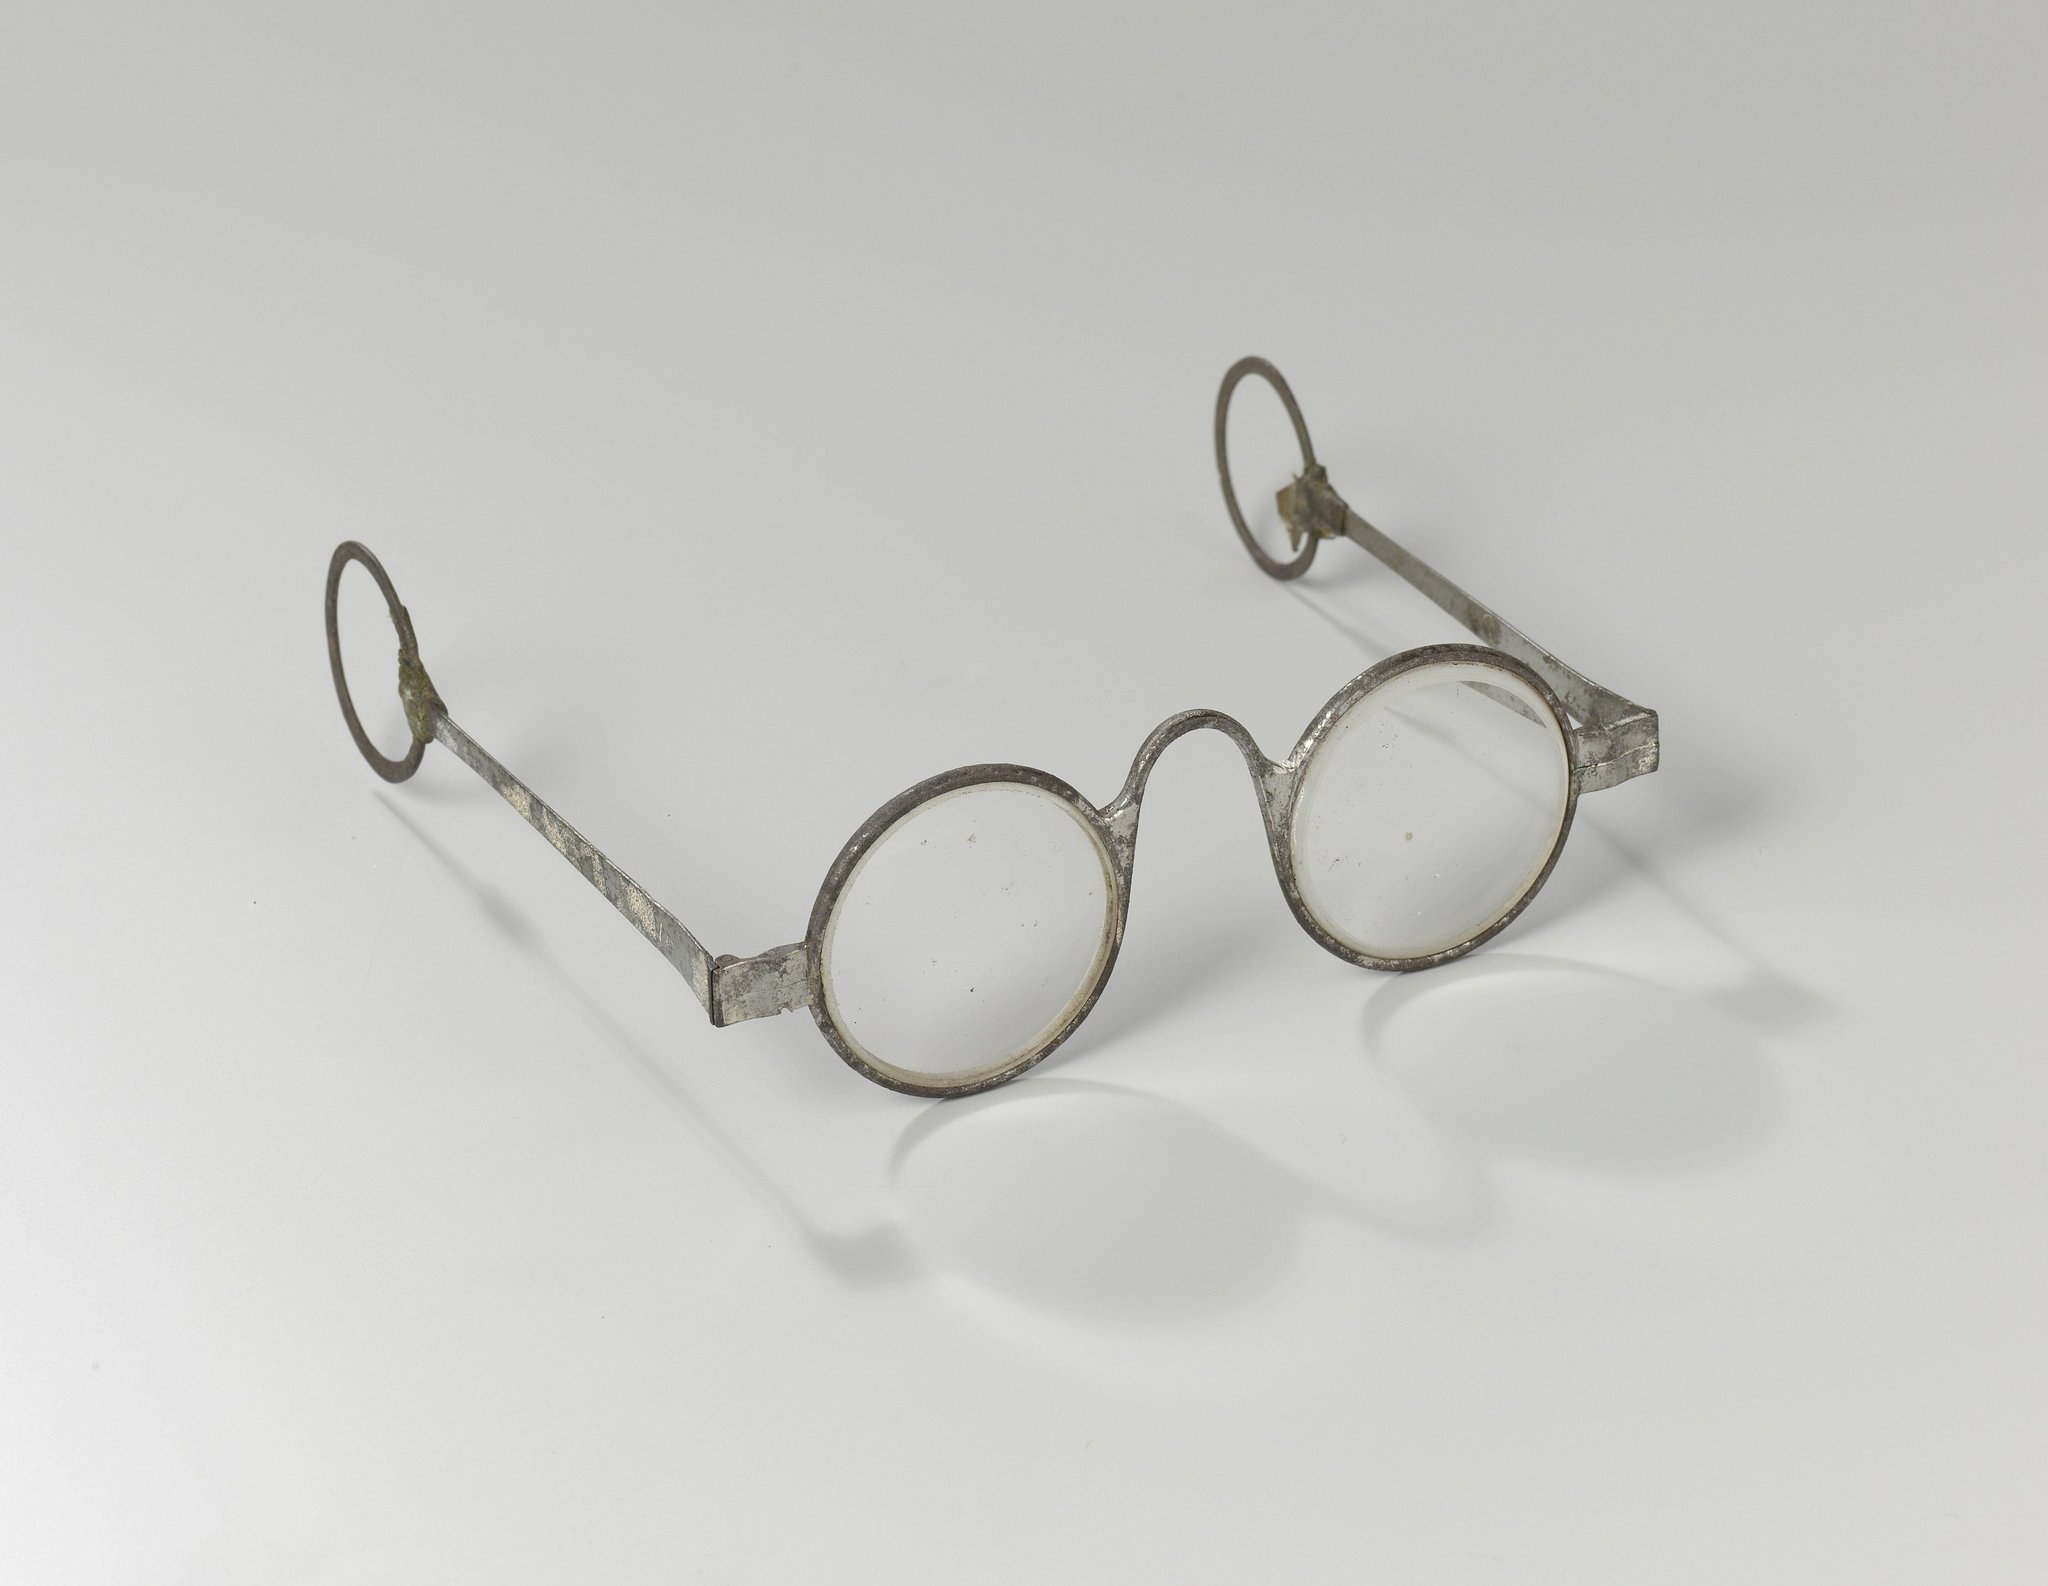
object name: spectacle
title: Bril met montuur van ijzer met benen eindigend in ringen, met ronde geslepen glazen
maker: Anonymous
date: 1700-1800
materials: glass, iron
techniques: casting, grinding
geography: netherlands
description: Bril met montuur van ijzer met benen eindigend in ringen, met ronde geslepen glazen.